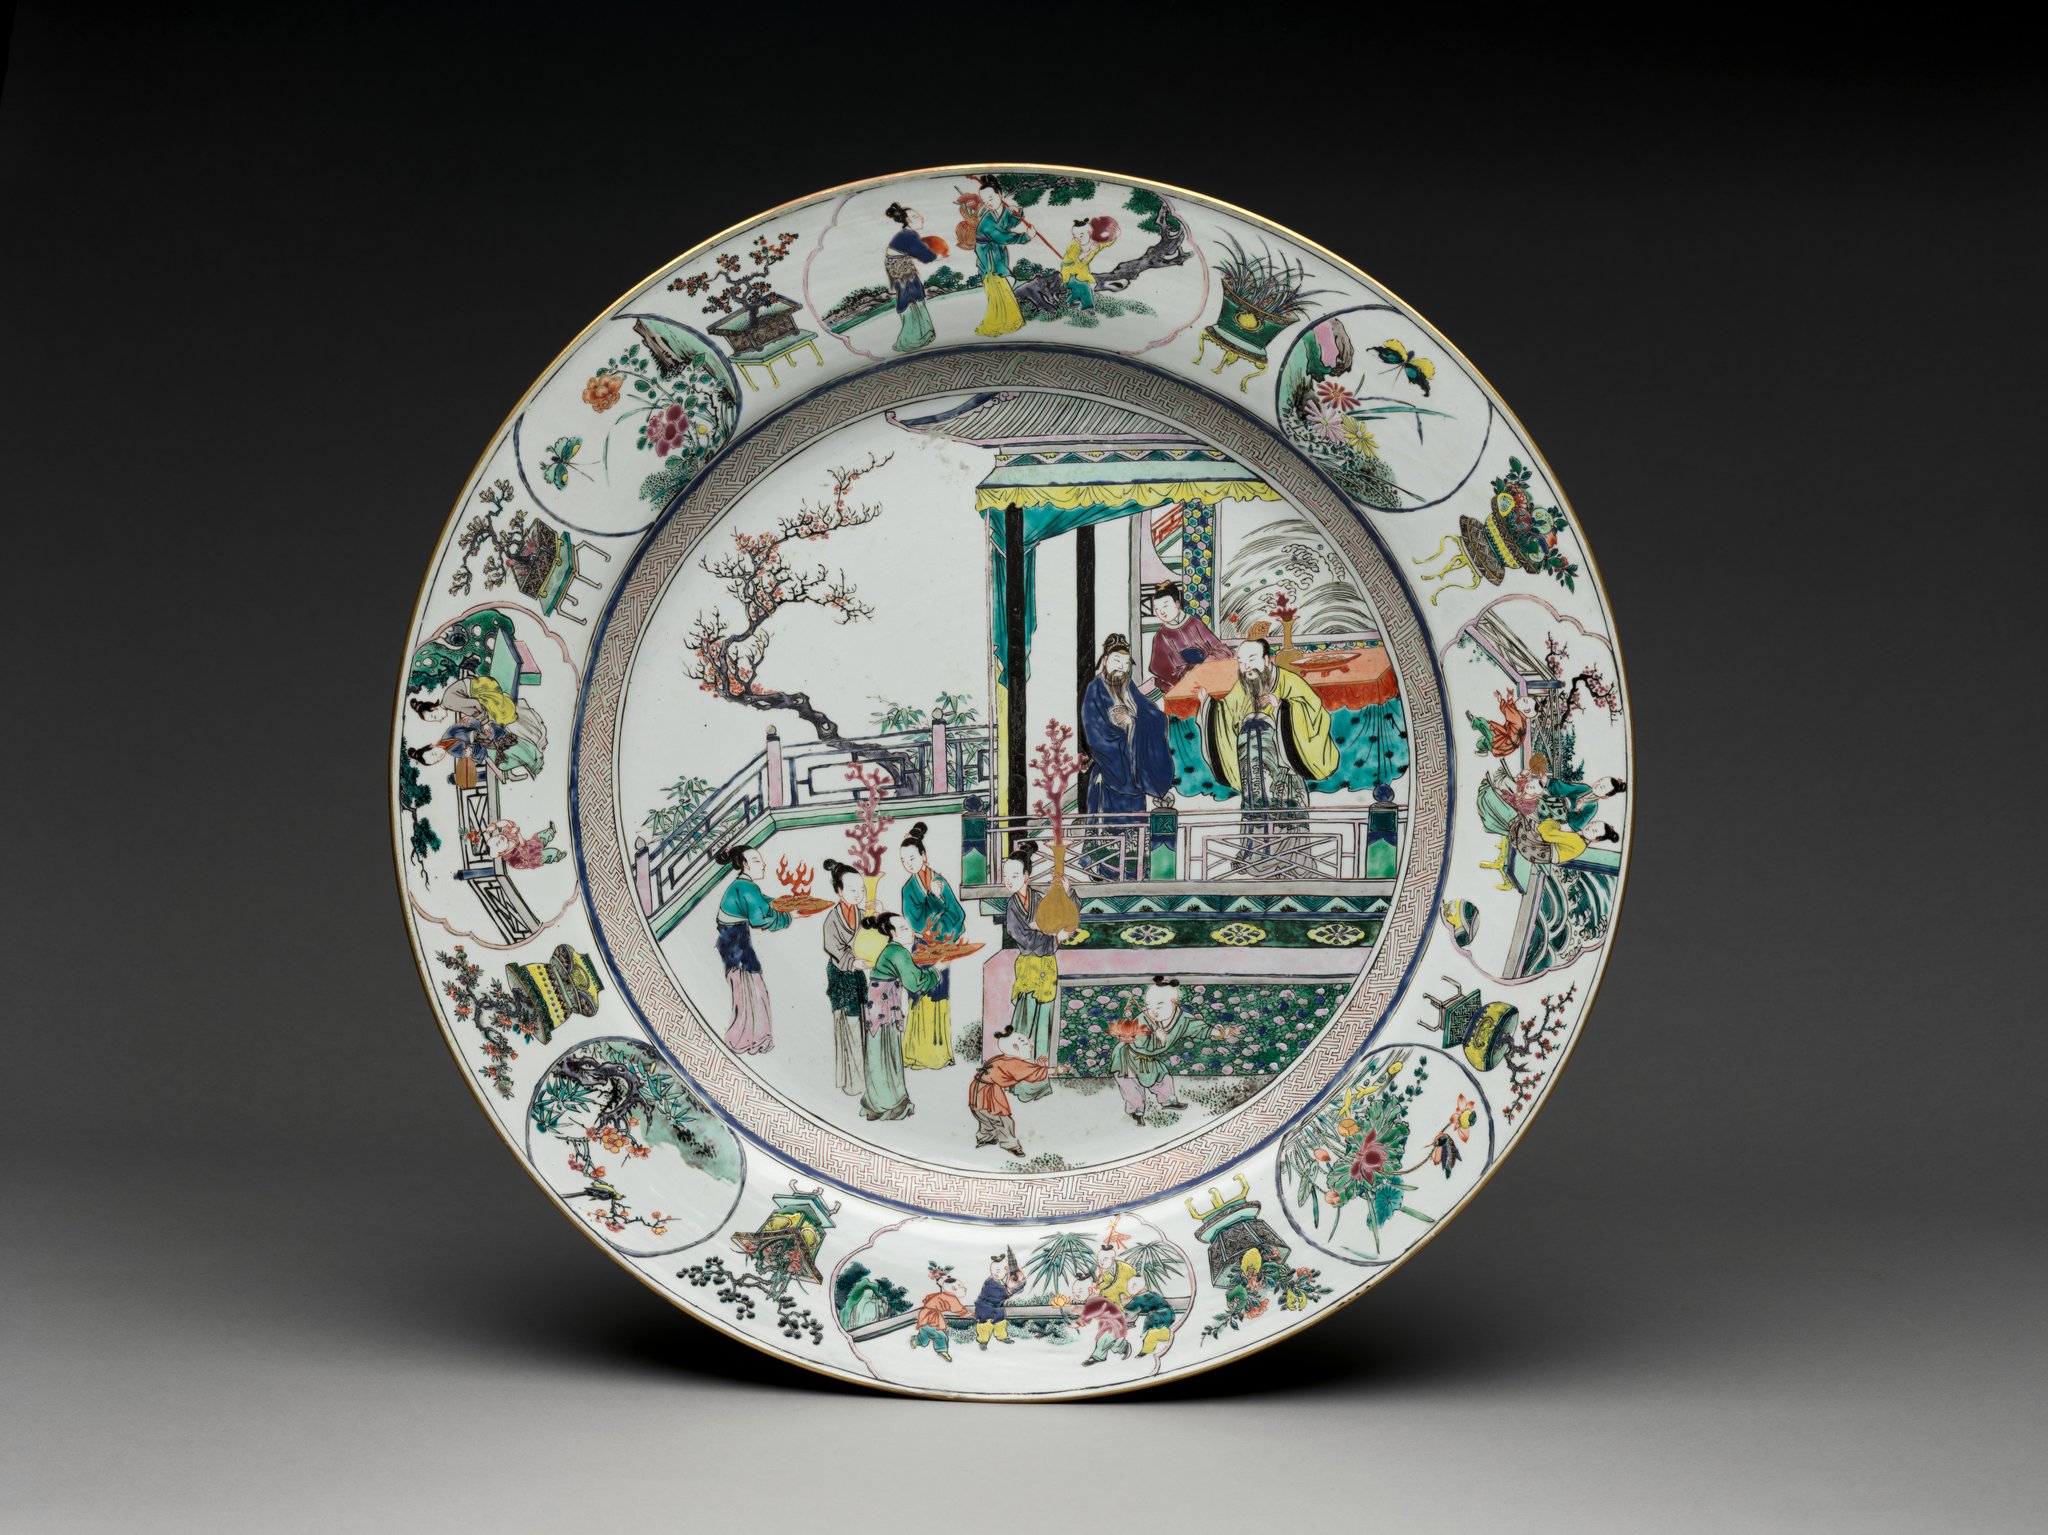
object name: plate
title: Plate with Scene of Offering Coral Plants to the Emperor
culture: chinese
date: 1701-1733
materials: biscuit, enamel, porcelain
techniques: painting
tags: emperors,children,men,women